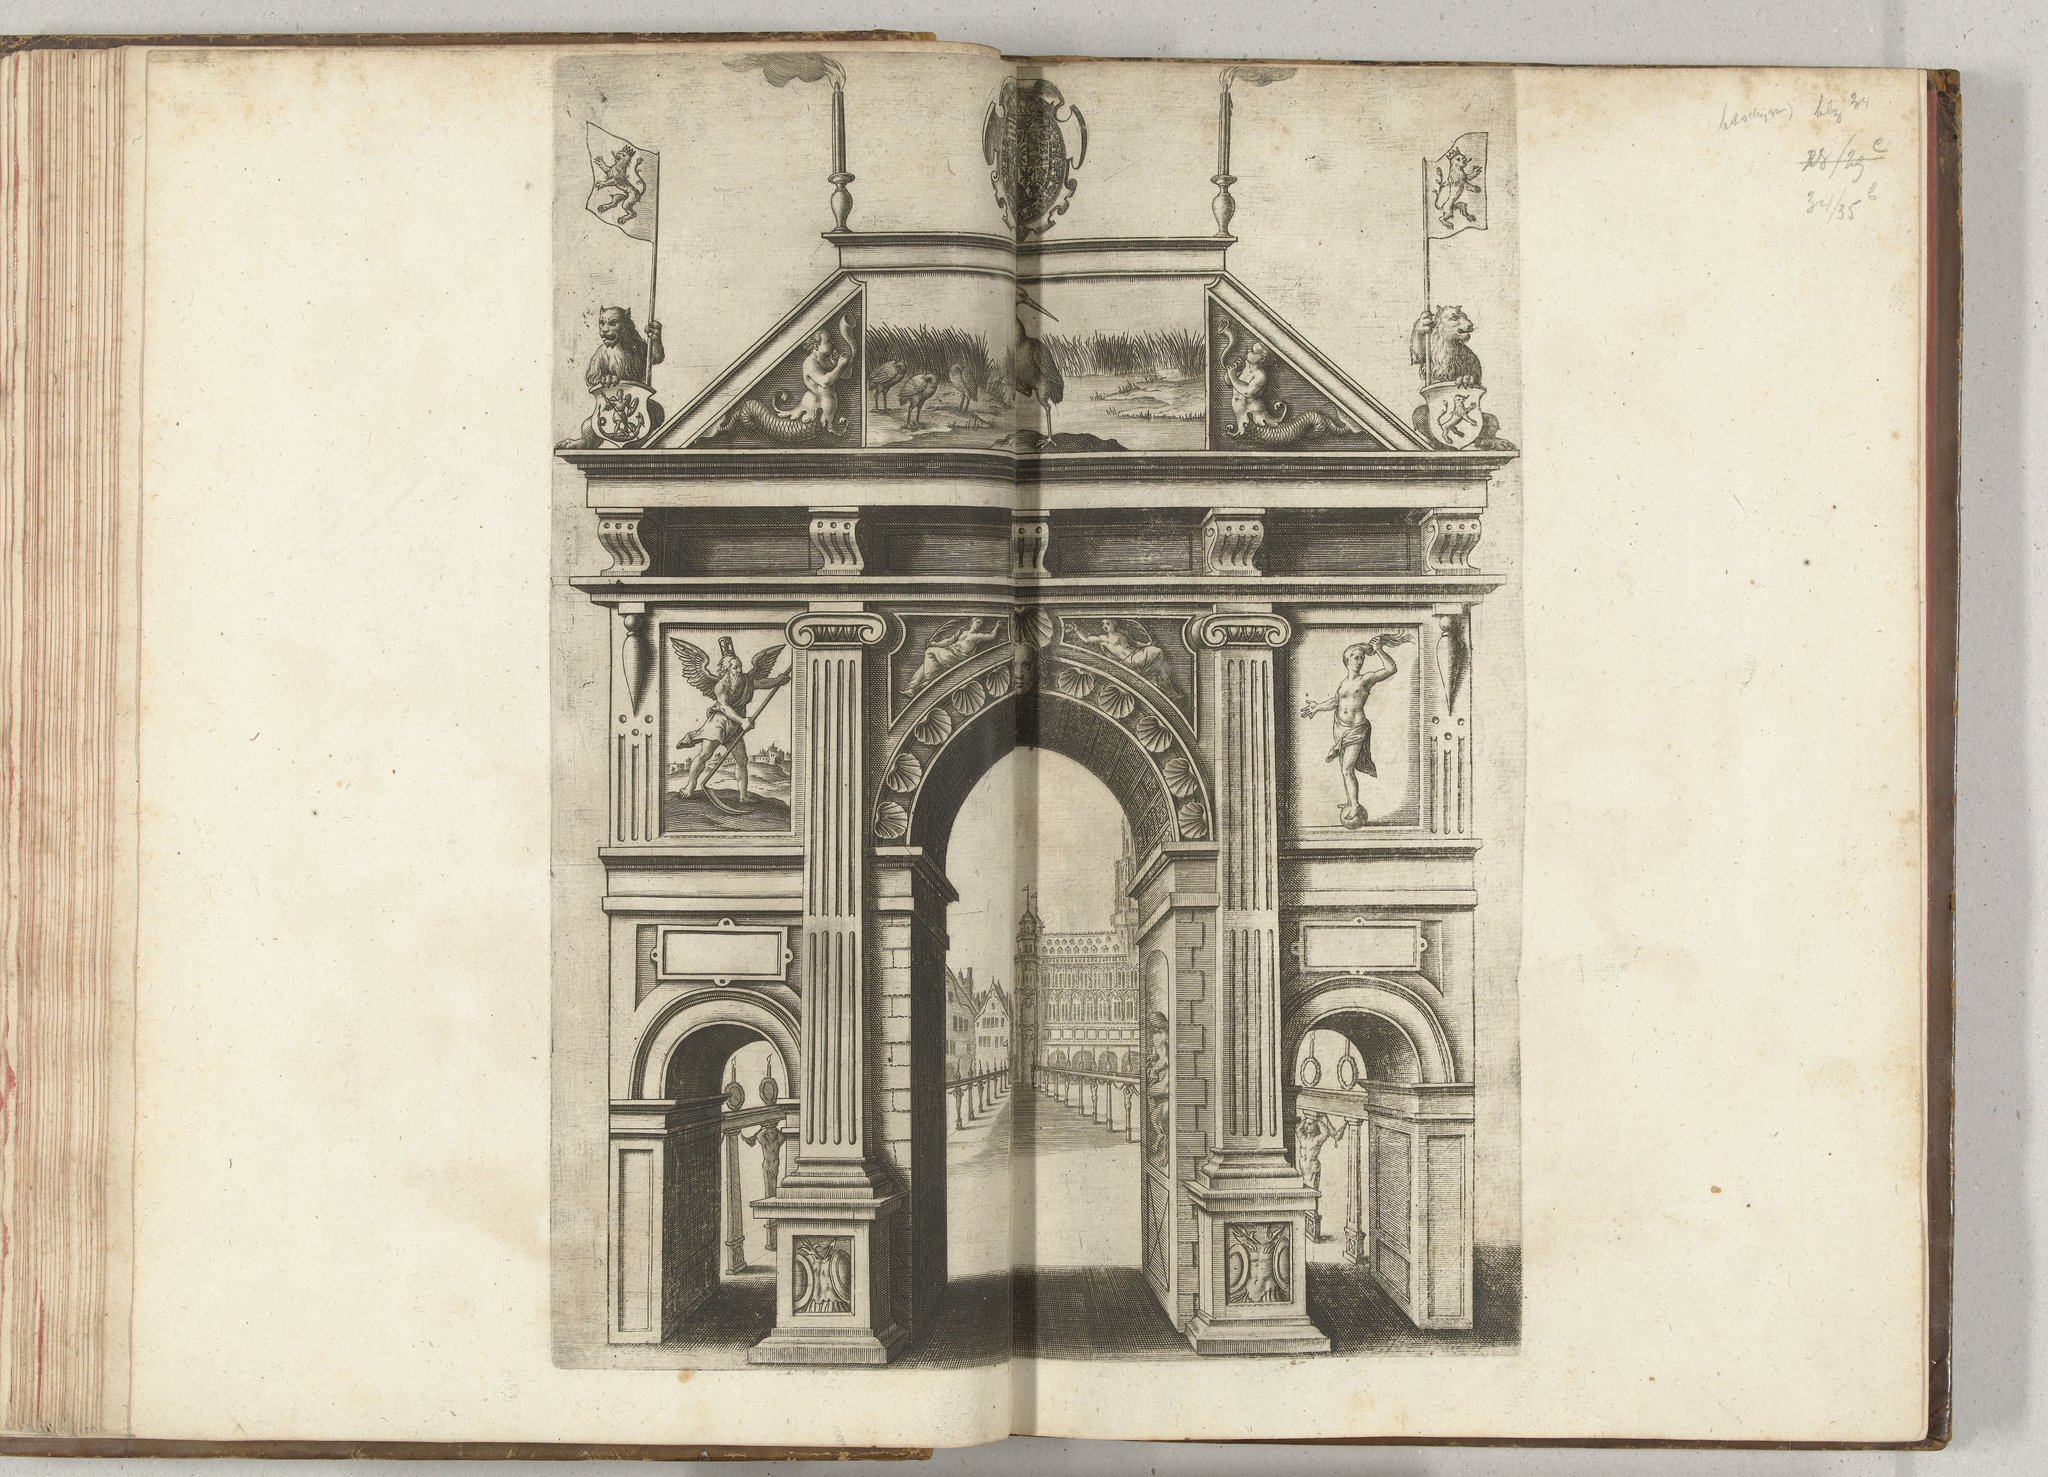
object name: print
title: Triomfpoort met de kraanvogel, 1594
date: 1594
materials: paper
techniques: engraving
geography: brussels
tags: vienna, brussels, triumphal entry and public reception, pageant, 'entrée solennelle', 'joyeuse entrée'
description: Triomfpoort naar de Grote Markt met het begin van de eregalerij. Bovenin een voorstelling van de waakzame kraanvogel, aan weerszijden Tijd en Fortuna. Feestelijke intocht van aartshertog Ernst als gouverneur der Nederlanden gehouden te Brussel op 30 januari 1594. Onderdeel van de beschrijving van deze intocht Descriptio et explicatio pegmatum, arcuum spectaculorum quae Bruxellae Brabant. pridie Cal. Febr. Ao. 1594 exhibita fuere, sub ingressum ... Ernesti ... Archiducis Austriae ... pro Philippo II. Belgicae ditionis gubernatore, J. Mommaert, Brussel 1594.